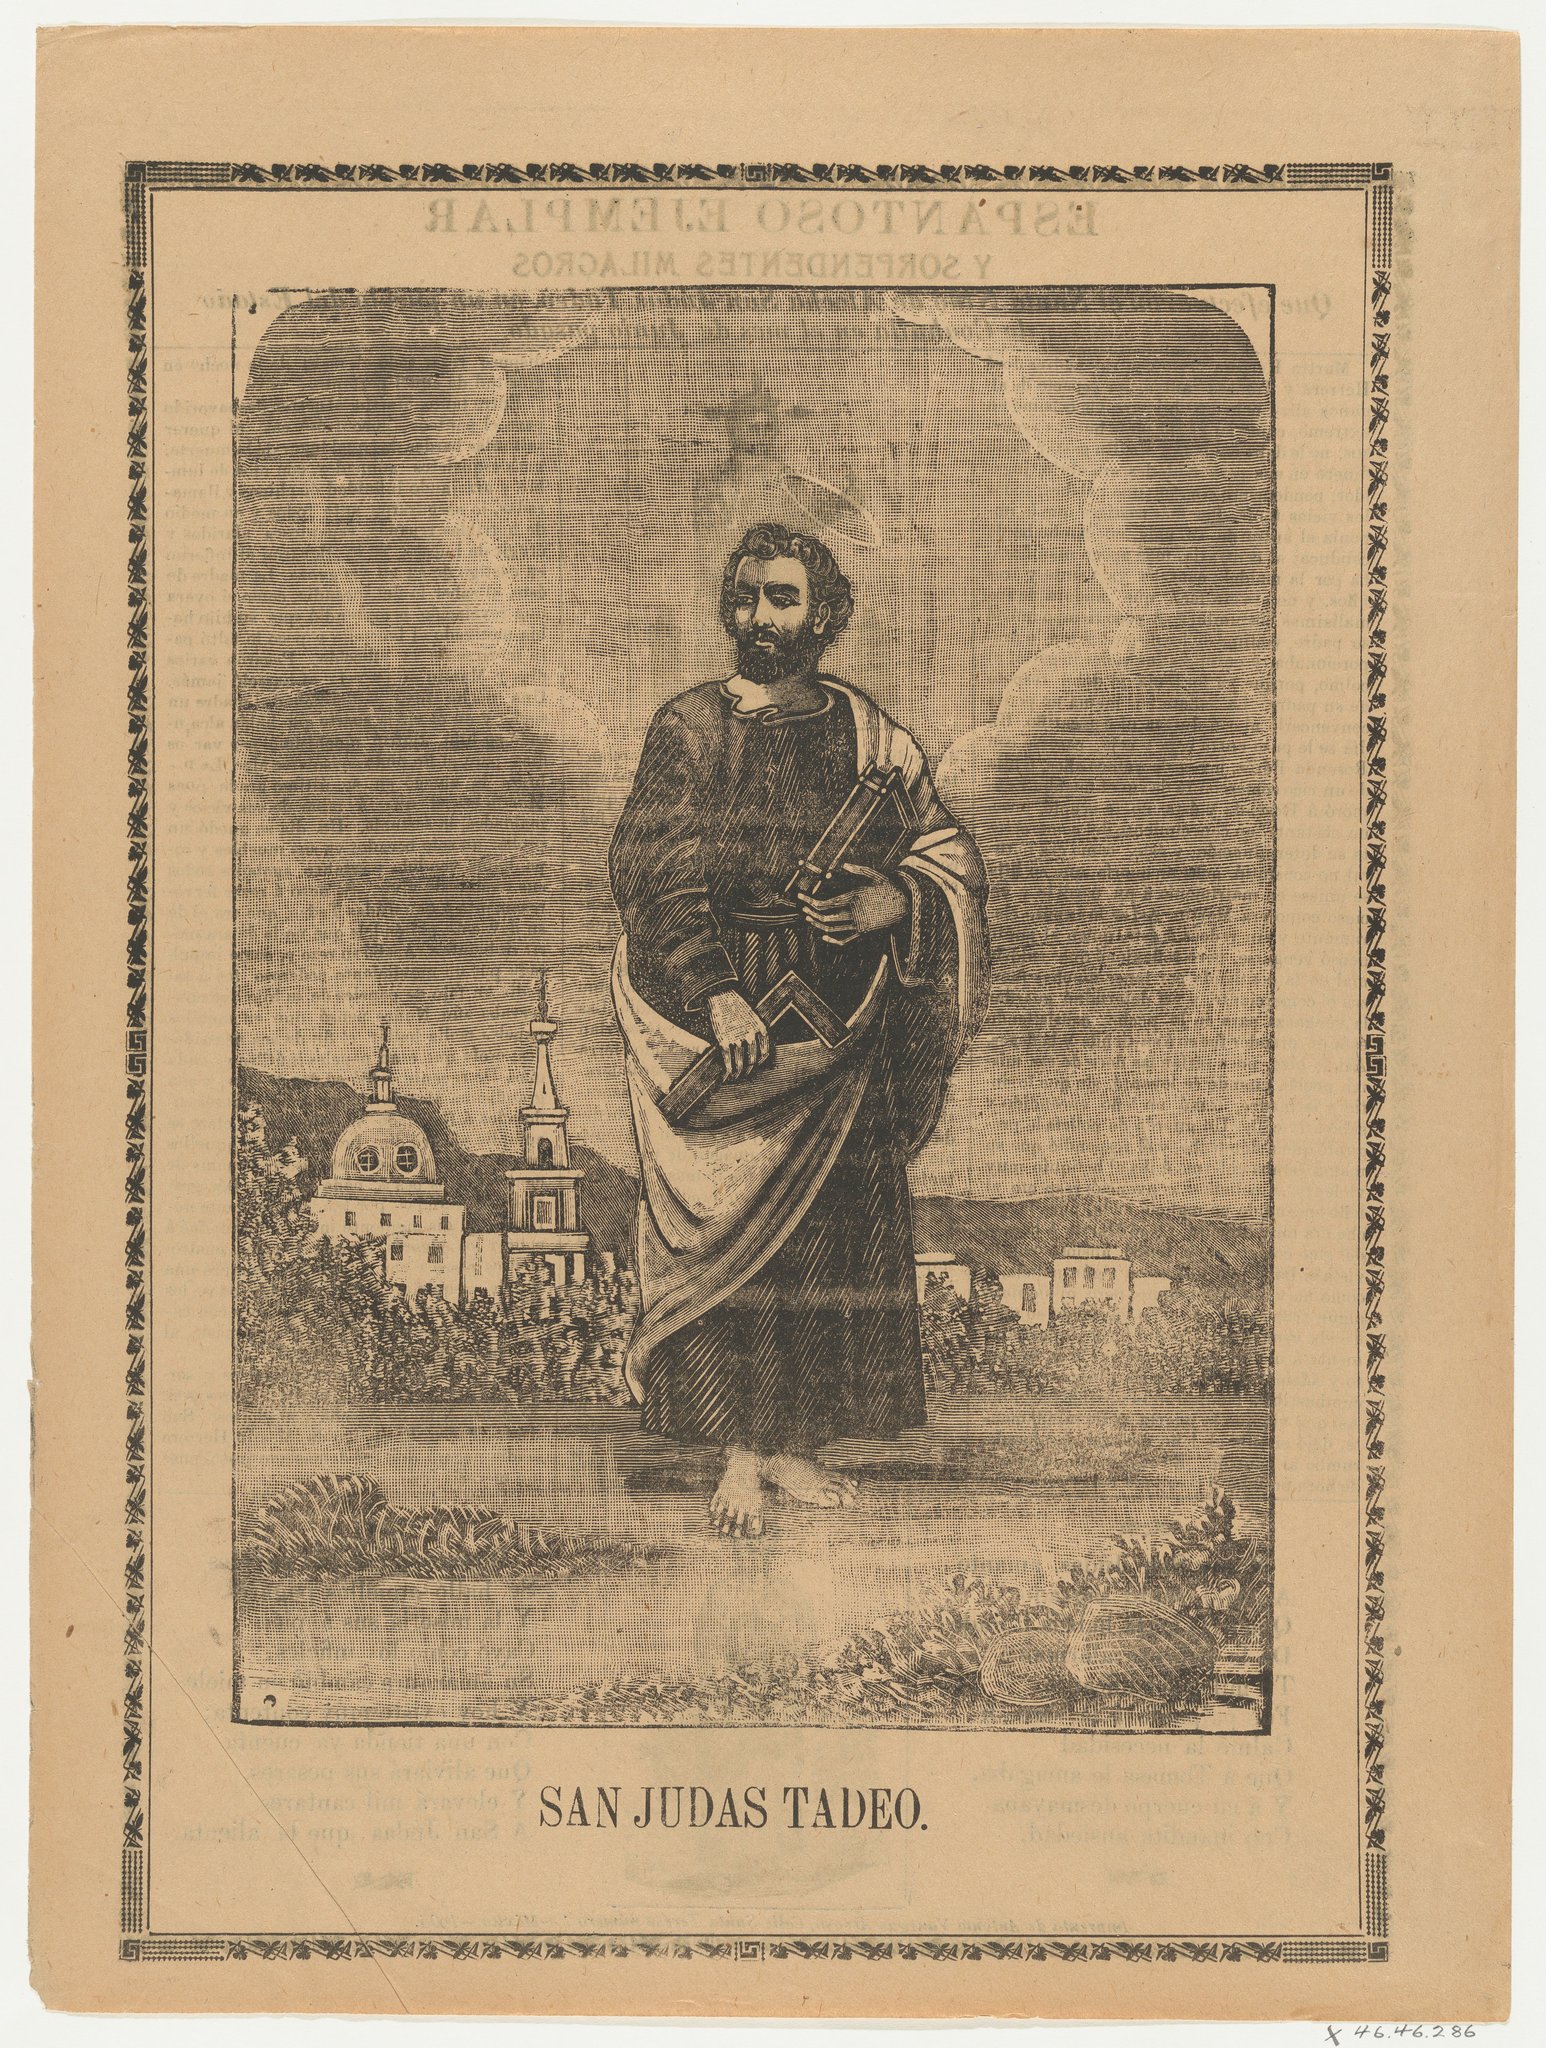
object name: print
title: Broadsheet depicting Saint Judas Thaddeus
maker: Anonymous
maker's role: artist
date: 1905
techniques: letterpress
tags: men,saints